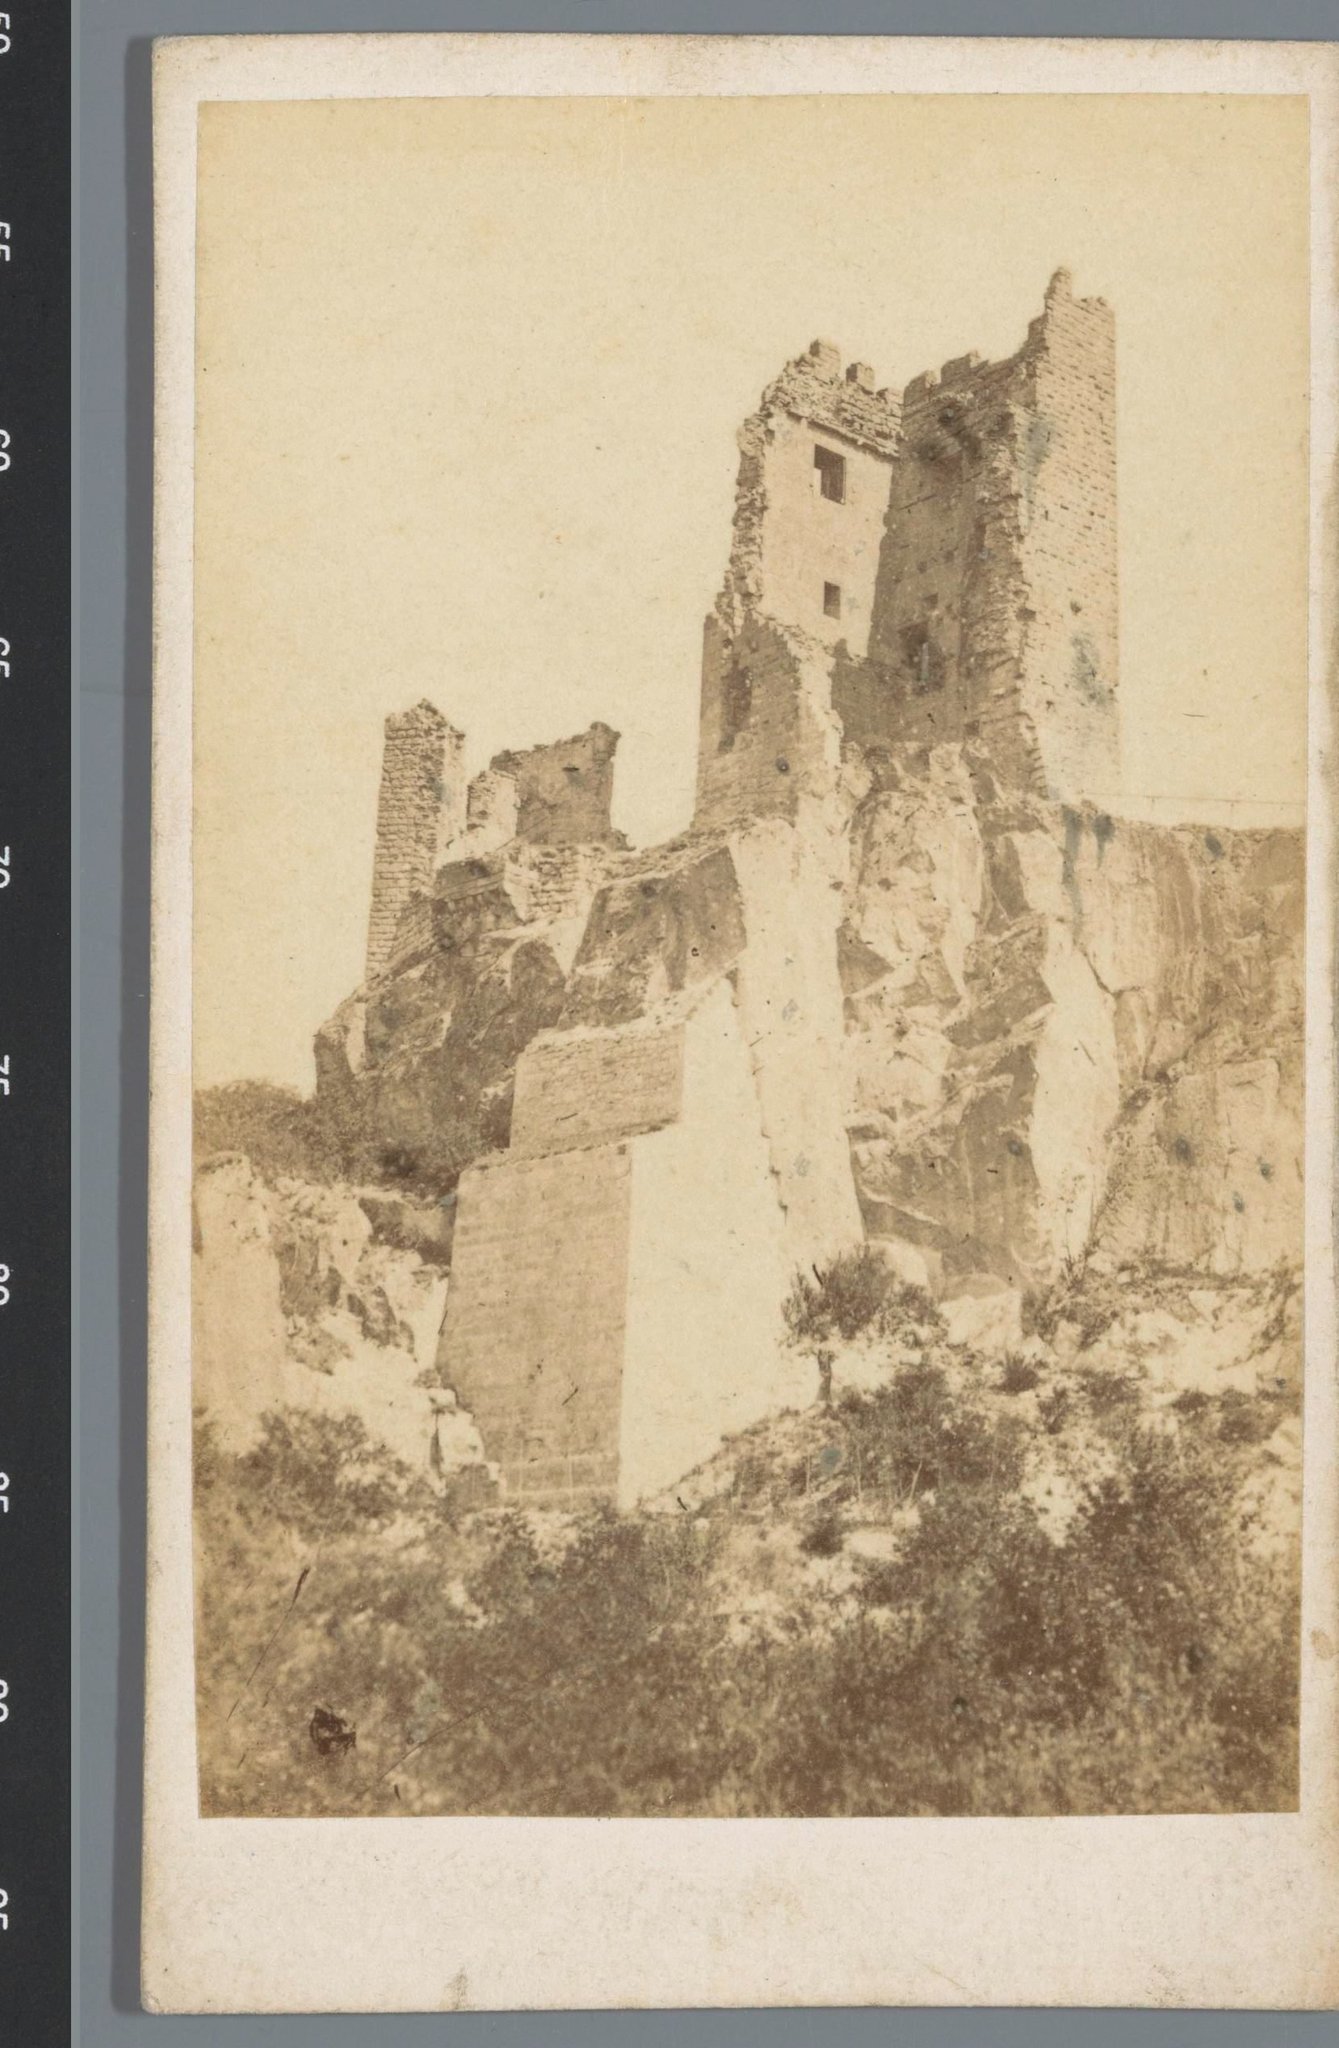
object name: carte de visite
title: Drachenfels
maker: Anonymous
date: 1855-1885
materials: cardboard, paper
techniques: albumen print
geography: drachenfels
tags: ruin of a dwelling, house, castle, etc.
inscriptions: number: ‘Nro. 77.’